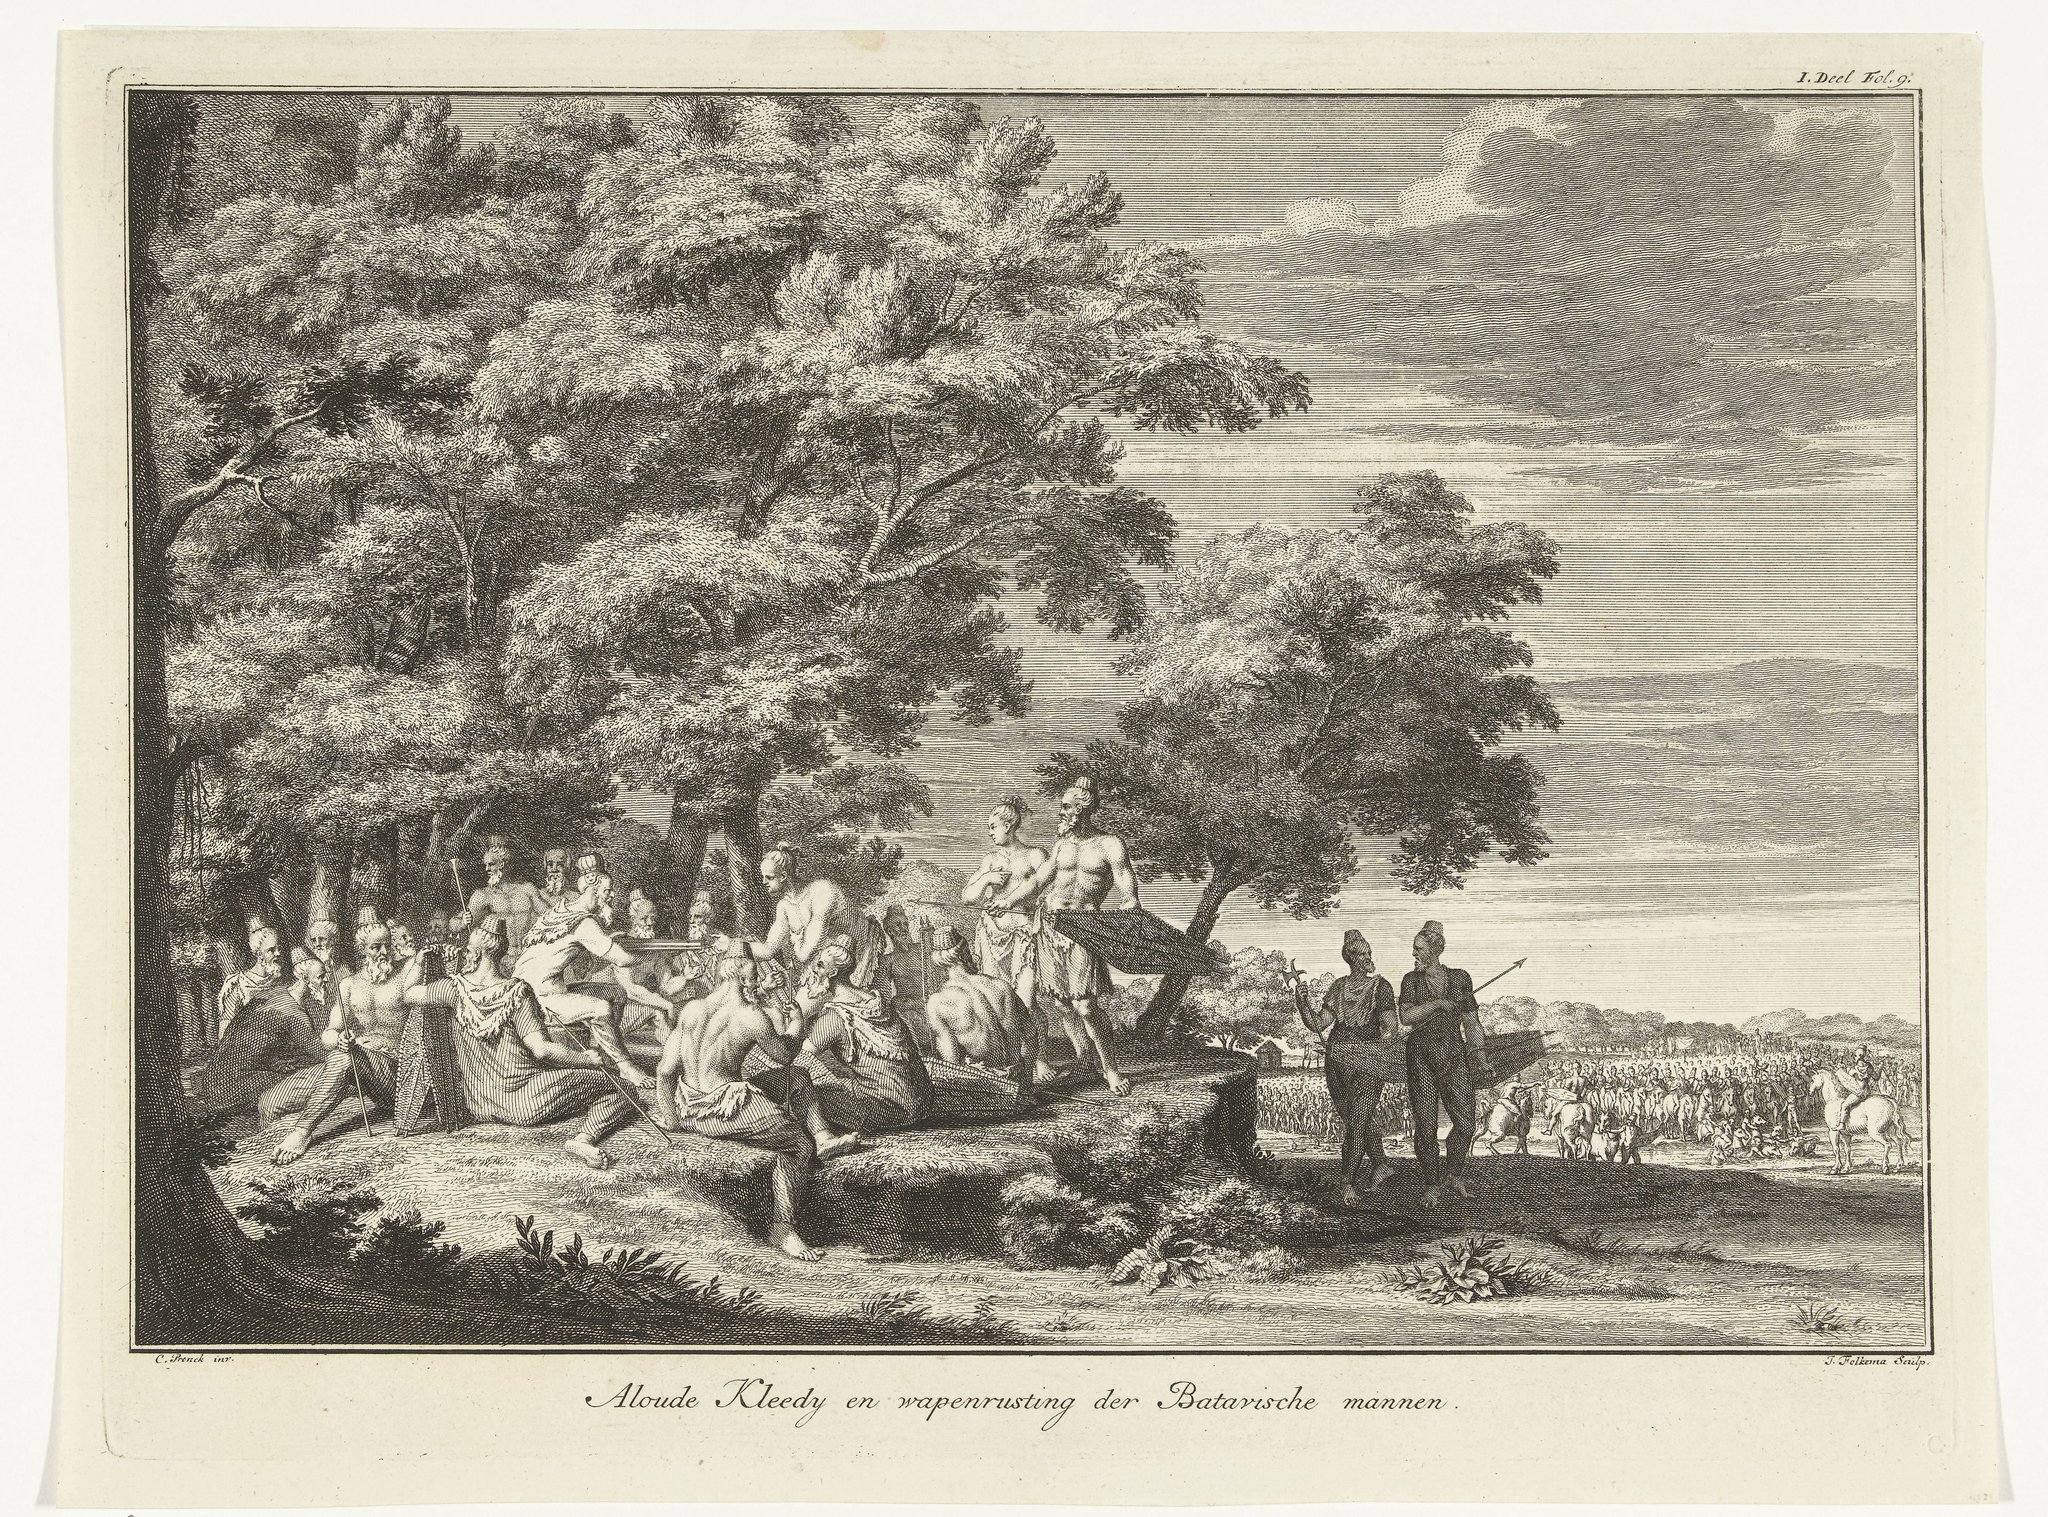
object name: print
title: Aloude Kleedy en wapenrusting der Batavische mannen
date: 1702-1767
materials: paper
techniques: etching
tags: extinct, 'historical' peoples (with name)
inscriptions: collector's mark: Lugt 1119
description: Bijeenkomst van gewapende Bataven, op de achtergrond stroomt een rivier waarachter troepen gewapende soldaten te paard opgesteld staan. Prent rechtsboven gemerkt: I. Deel Fol. 9.